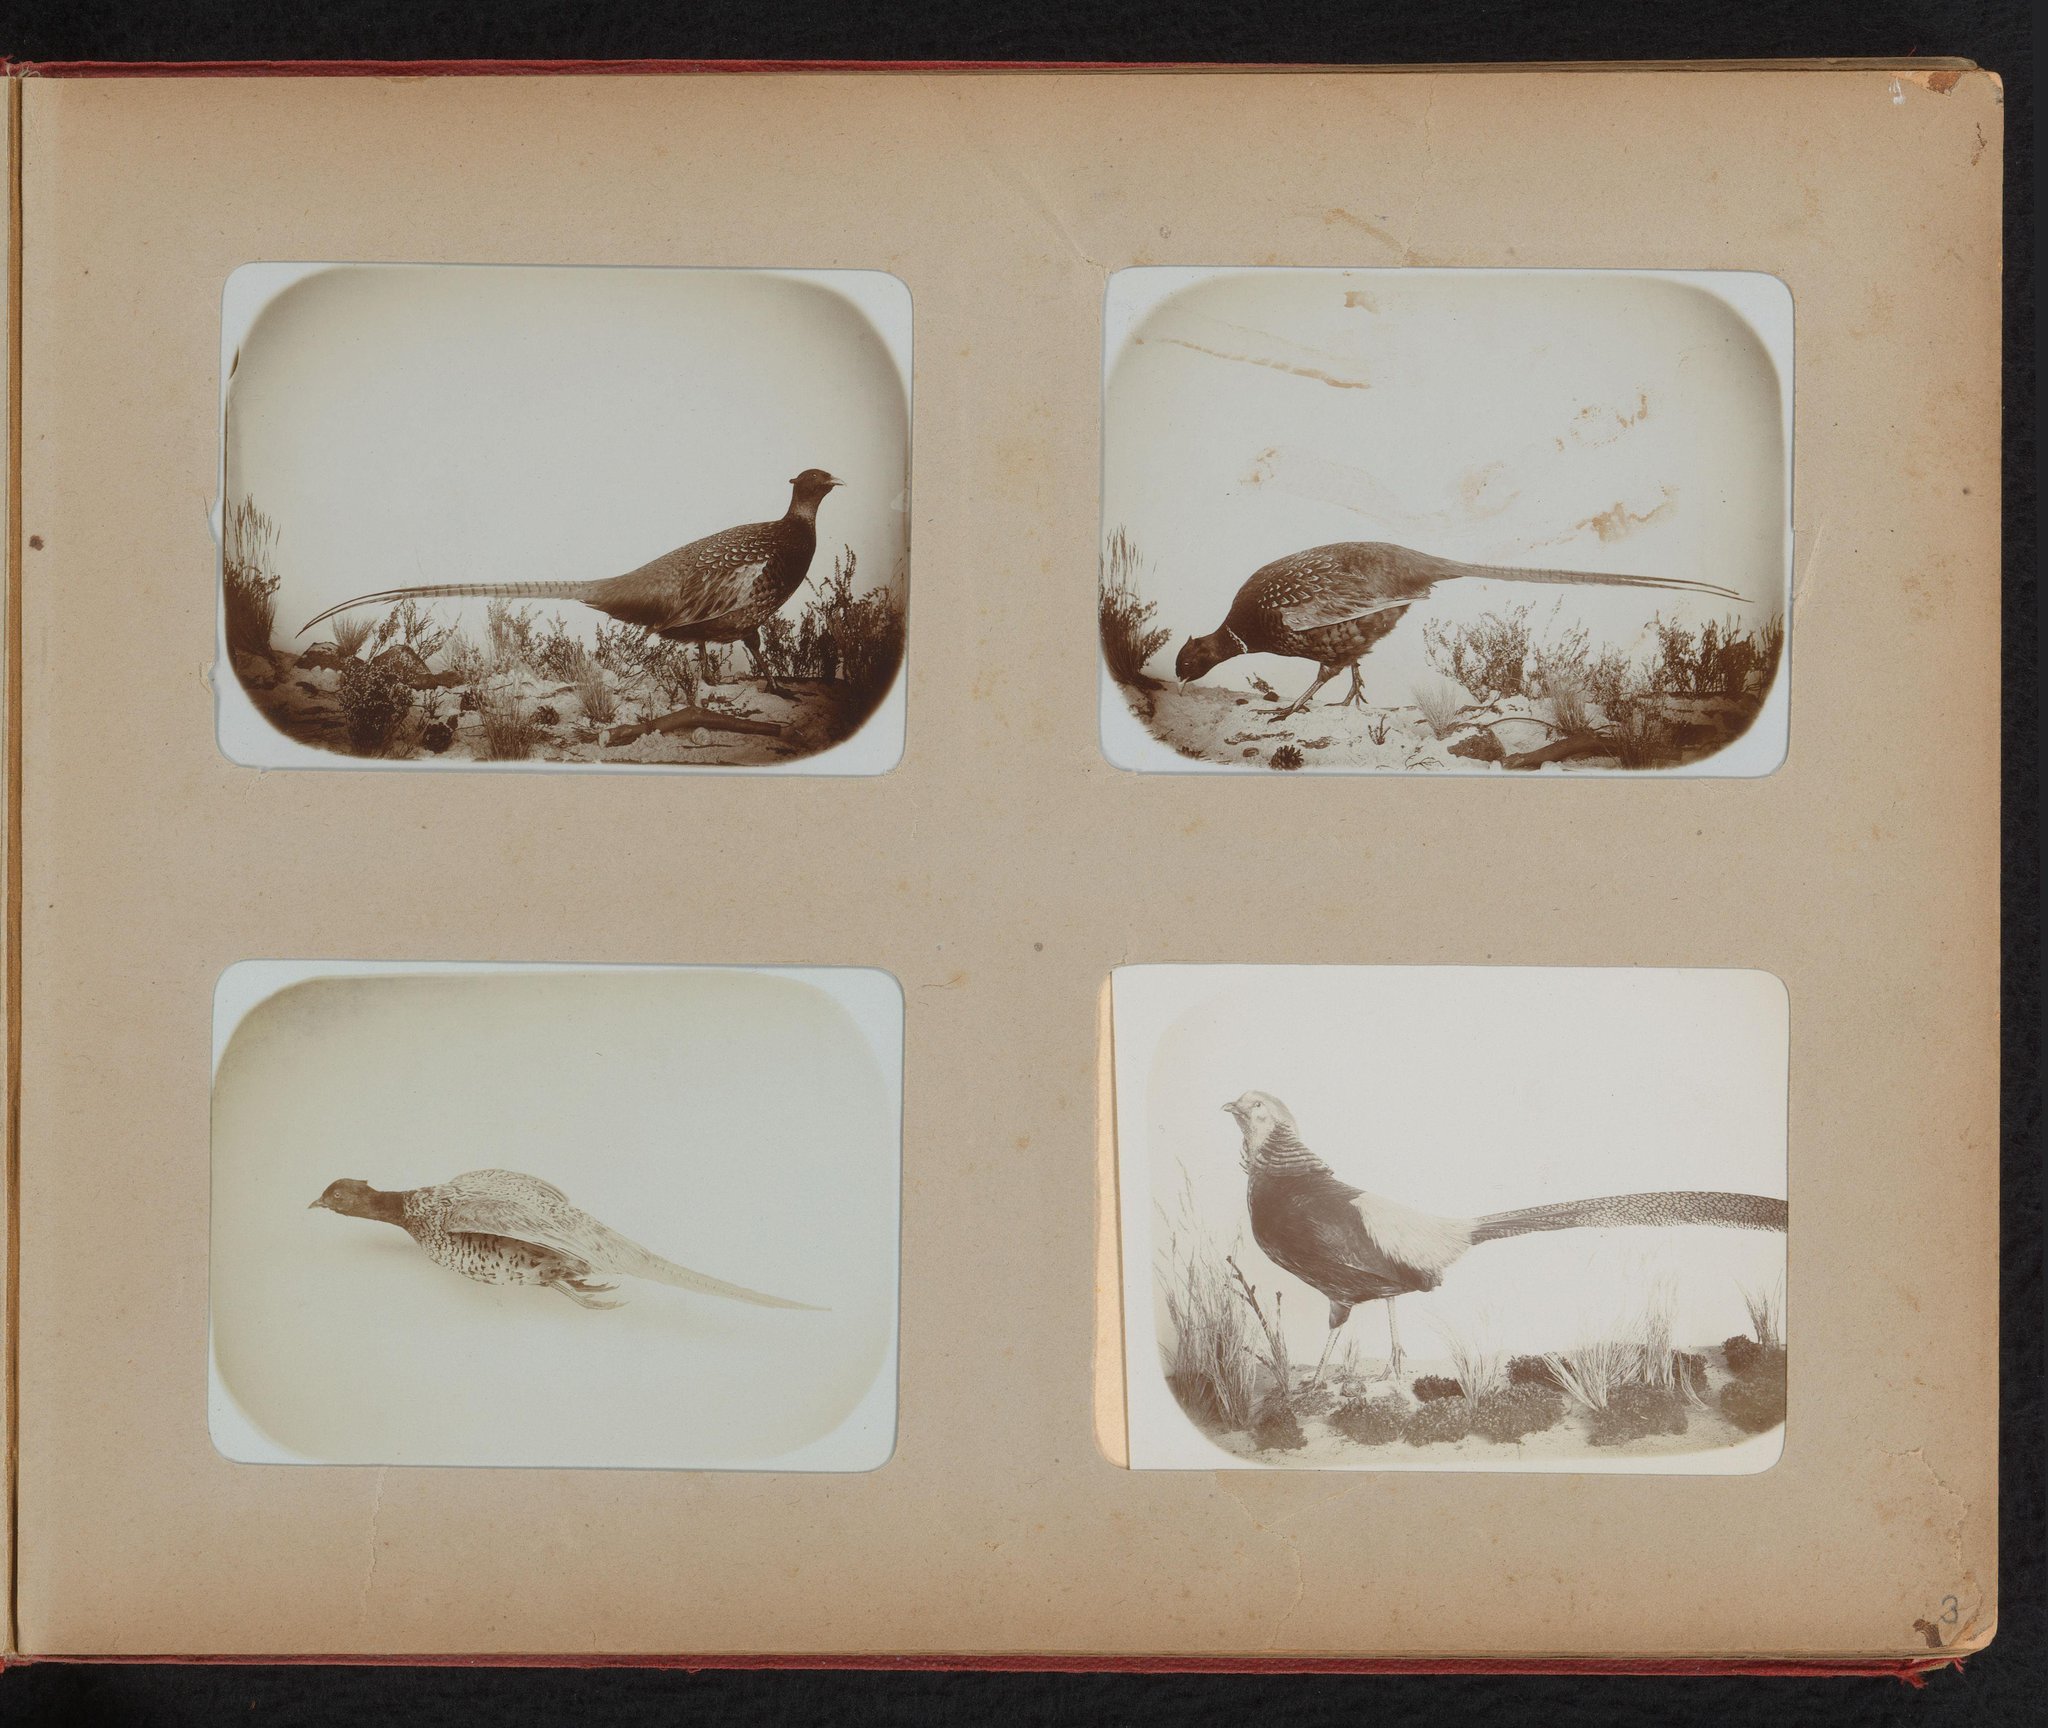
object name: album leaf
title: Vier opgezette fazanten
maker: Anonymous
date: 1895-1910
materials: paper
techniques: gelatin silver print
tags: walker and runner birds: pheasant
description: Deze foto's maken deel uit van een album.